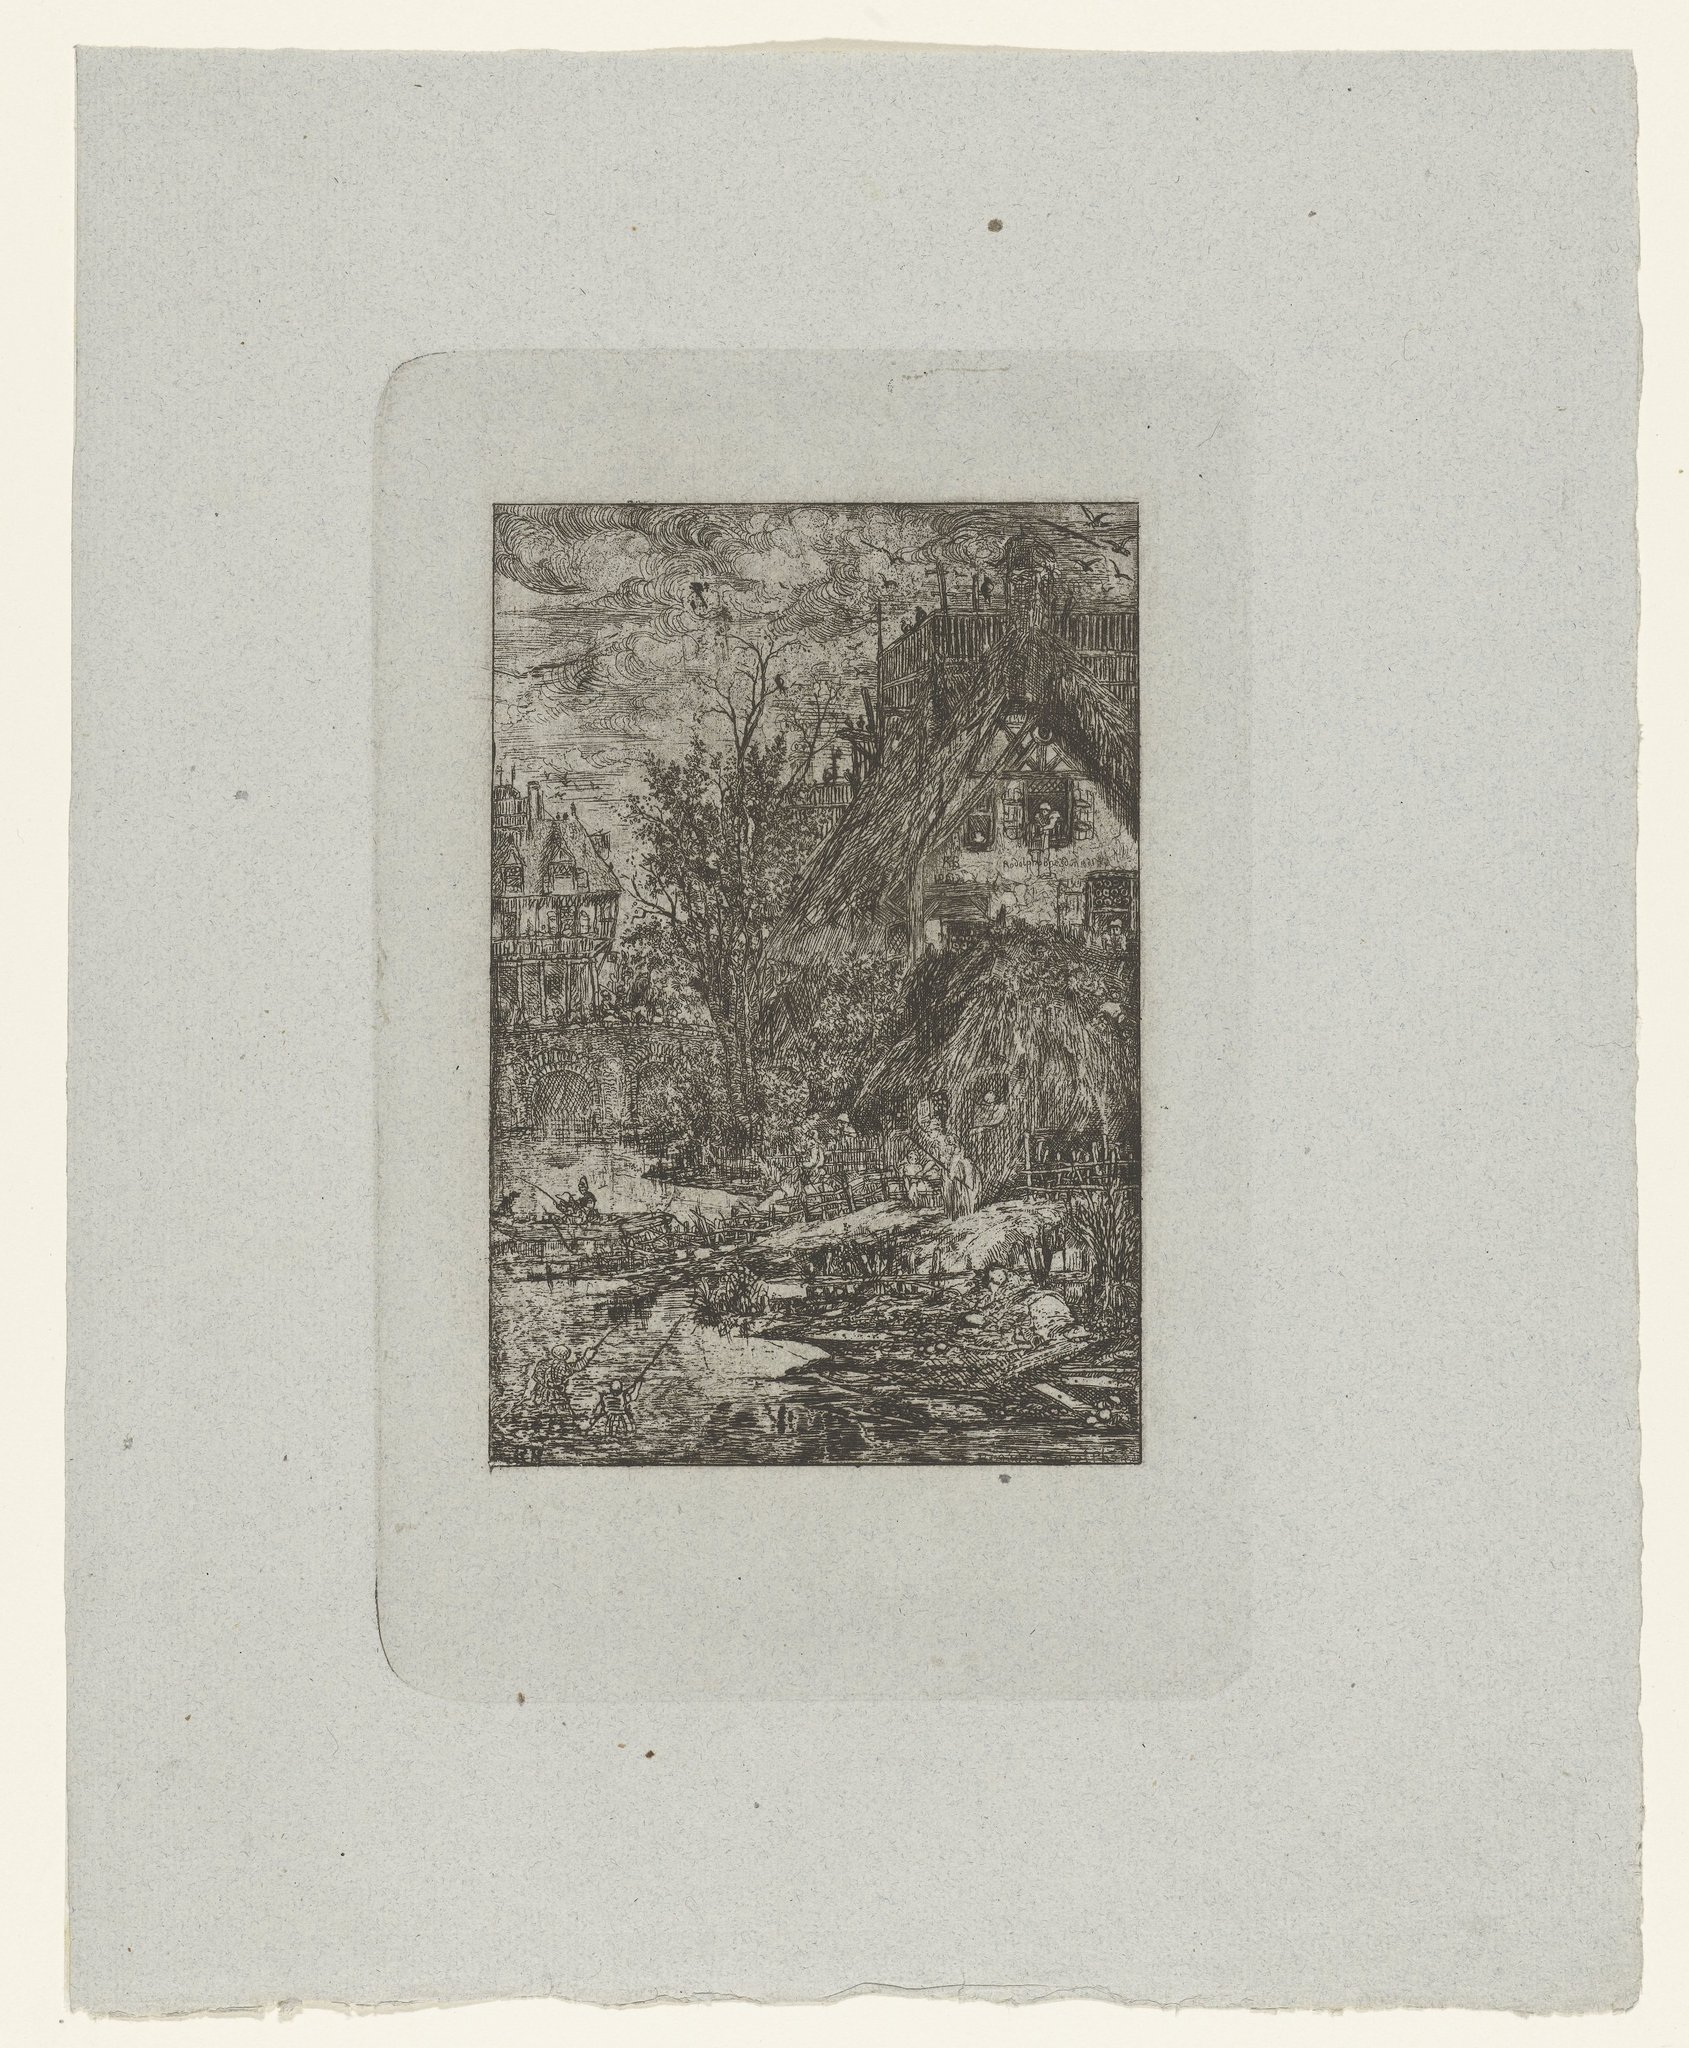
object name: print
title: Entrée de village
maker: rodolphe bresdin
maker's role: draughtsman, print maker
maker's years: 1822-1885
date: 1861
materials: paper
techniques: etching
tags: village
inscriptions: collector's mark: Lugt 2228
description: Dorpsgezicht met een rivier. Rechts op de oever staan huizen op een rij langs de rivier die met een bocht links onder een brug het dorp in loopt. Op de voorgrond staan vissers met hengels in het ondiepe water.